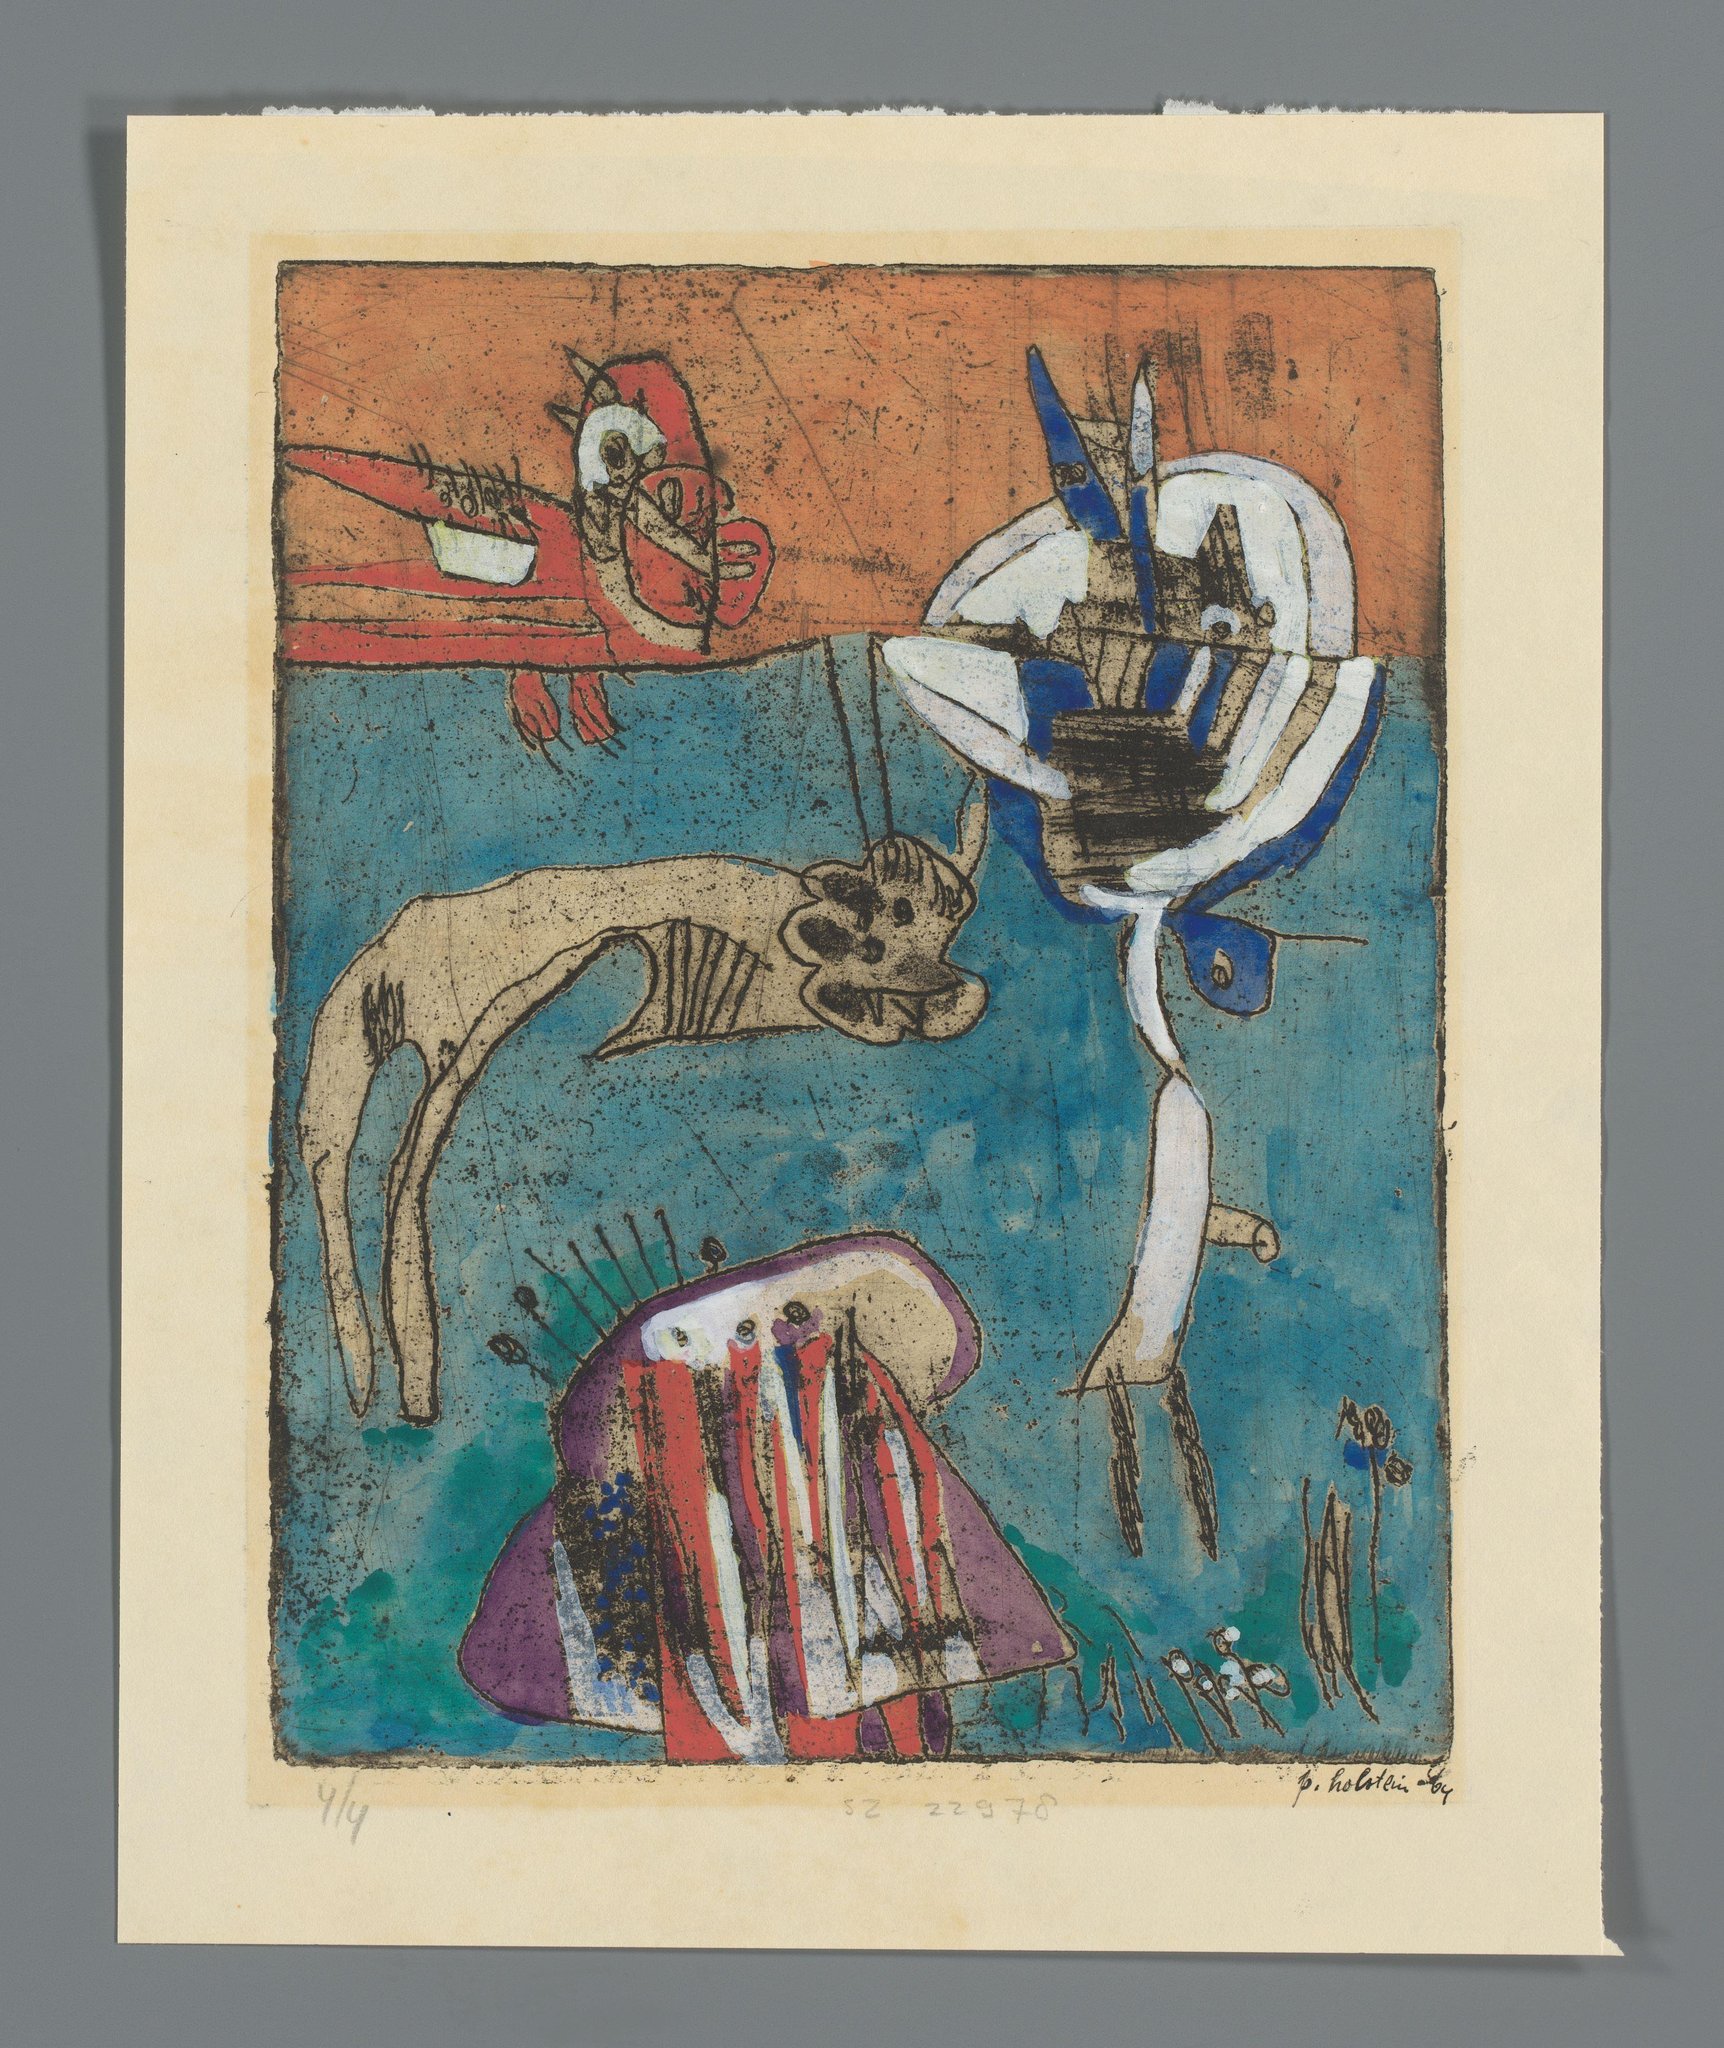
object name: print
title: Ets 2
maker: pieter holstein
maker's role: draughtsman, painter, print maker, sculptor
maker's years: 1934-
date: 1964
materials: gouache, paper, ink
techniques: drypoint, etching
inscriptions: signature and date: ‘p. holstein '64’, edition: ‘4/4’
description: Surrealistische compositie met boven het midden een horizon, daaronder wezens tegen een blauw fond en daarboven een wezen in wit en rood tegen een oranje fond.